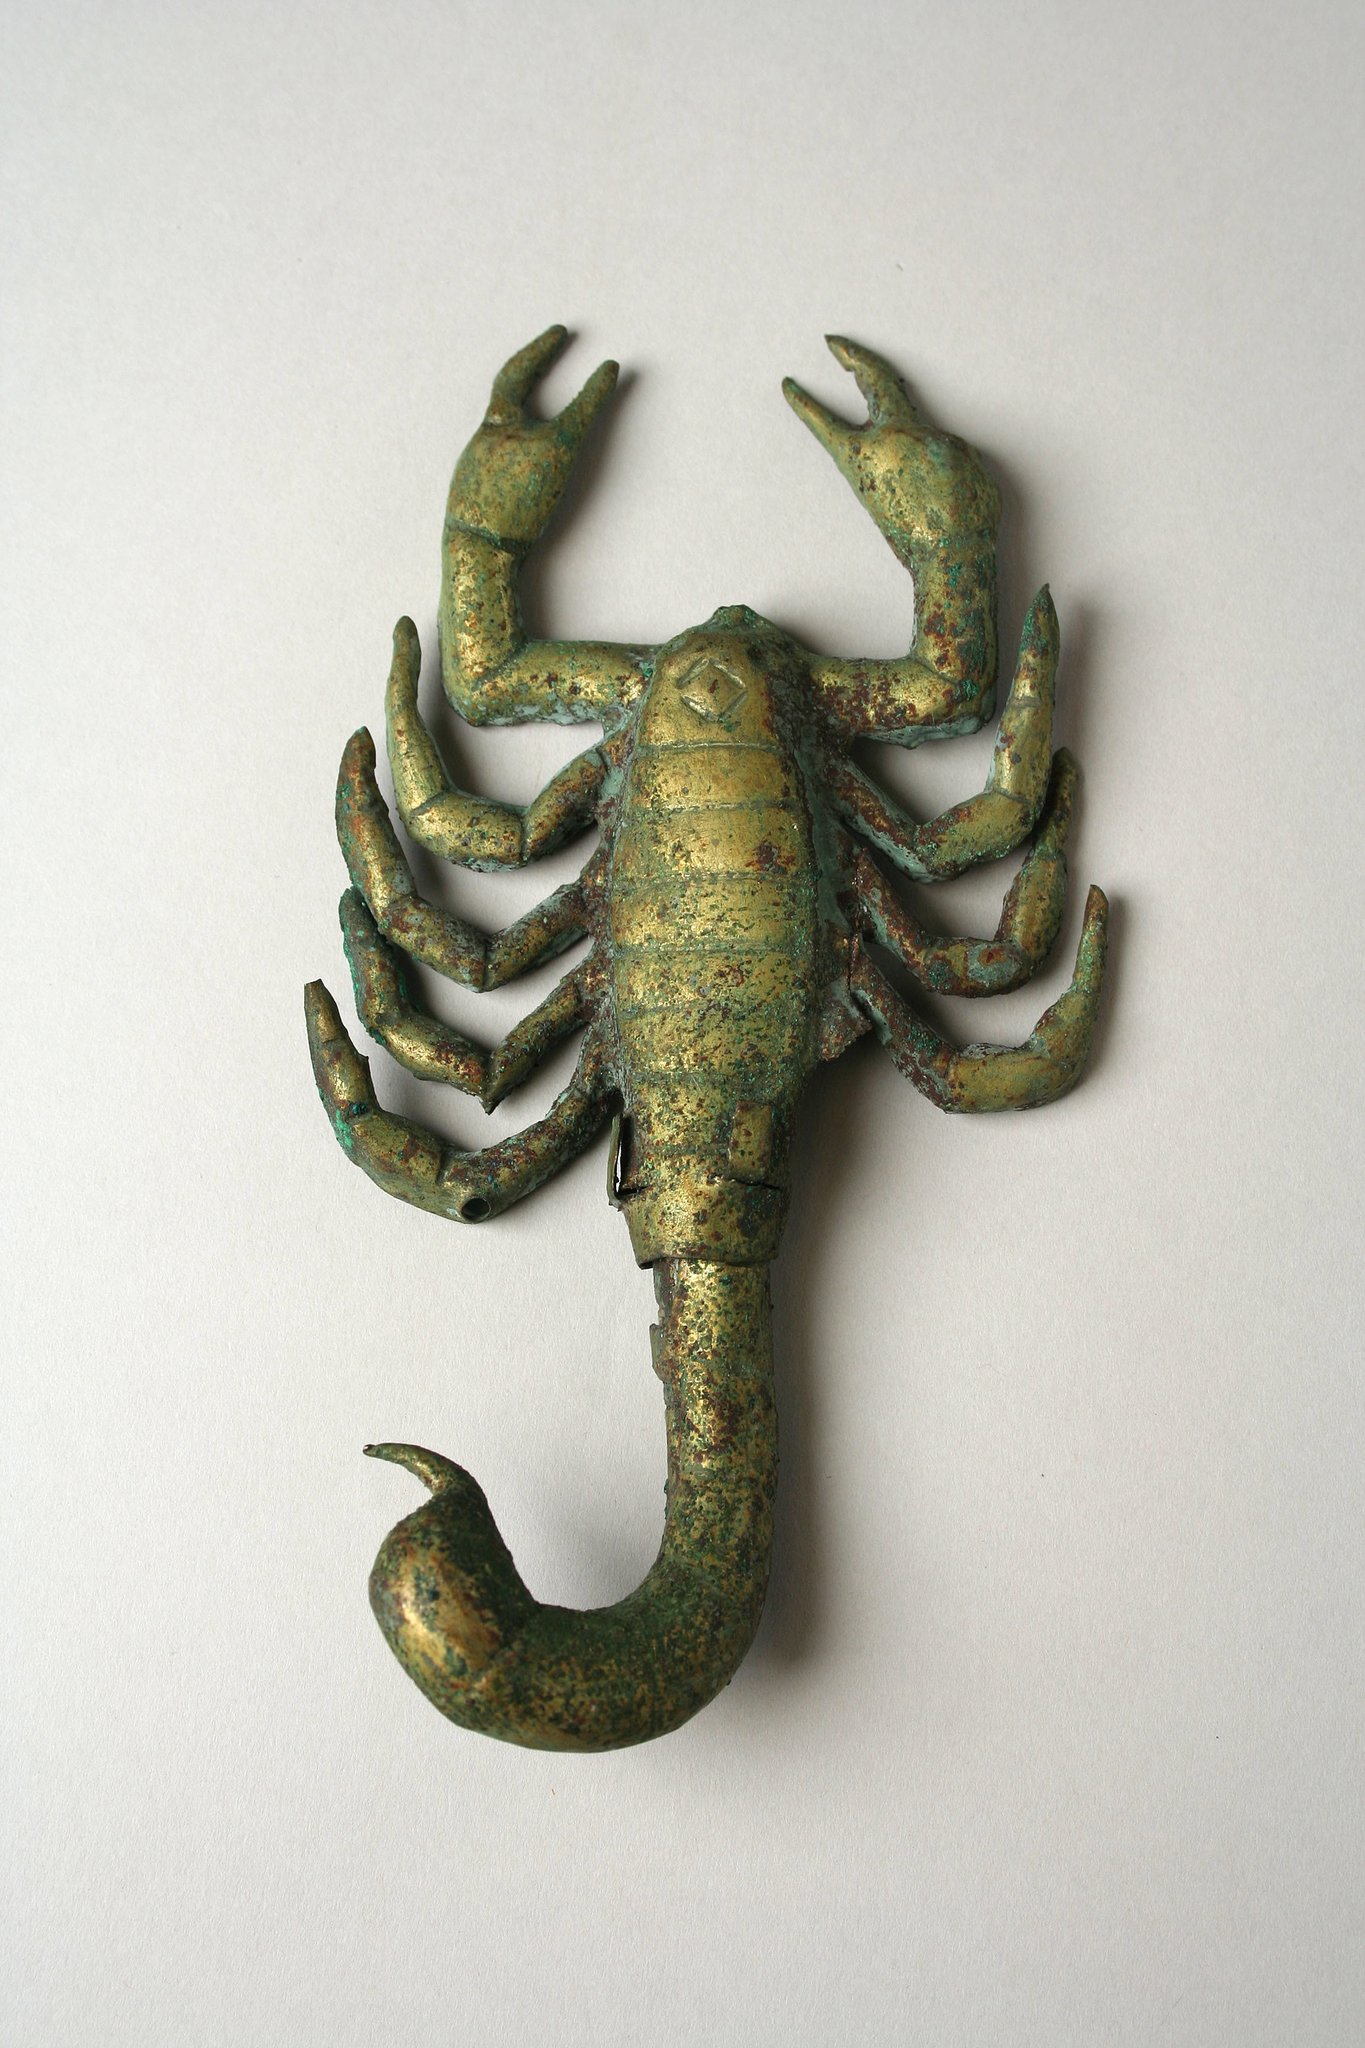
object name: ornament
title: Scorpion Ornament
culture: moche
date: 501-700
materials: metal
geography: peru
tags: scorpions